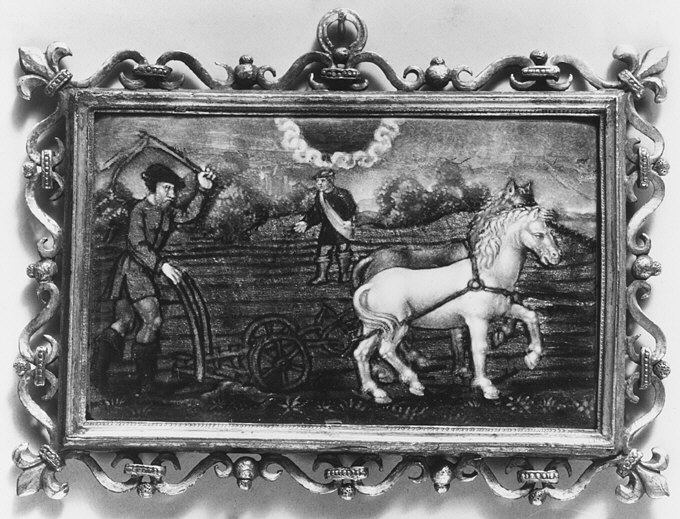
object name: plaque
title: The Labors of the Months: Ploughing (September)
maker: jean ii pénicaud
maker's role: maker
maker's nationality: french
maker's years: 1524-1554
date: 1534-1566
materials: copper, enamel, gilt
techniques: painting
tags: men,horses,working